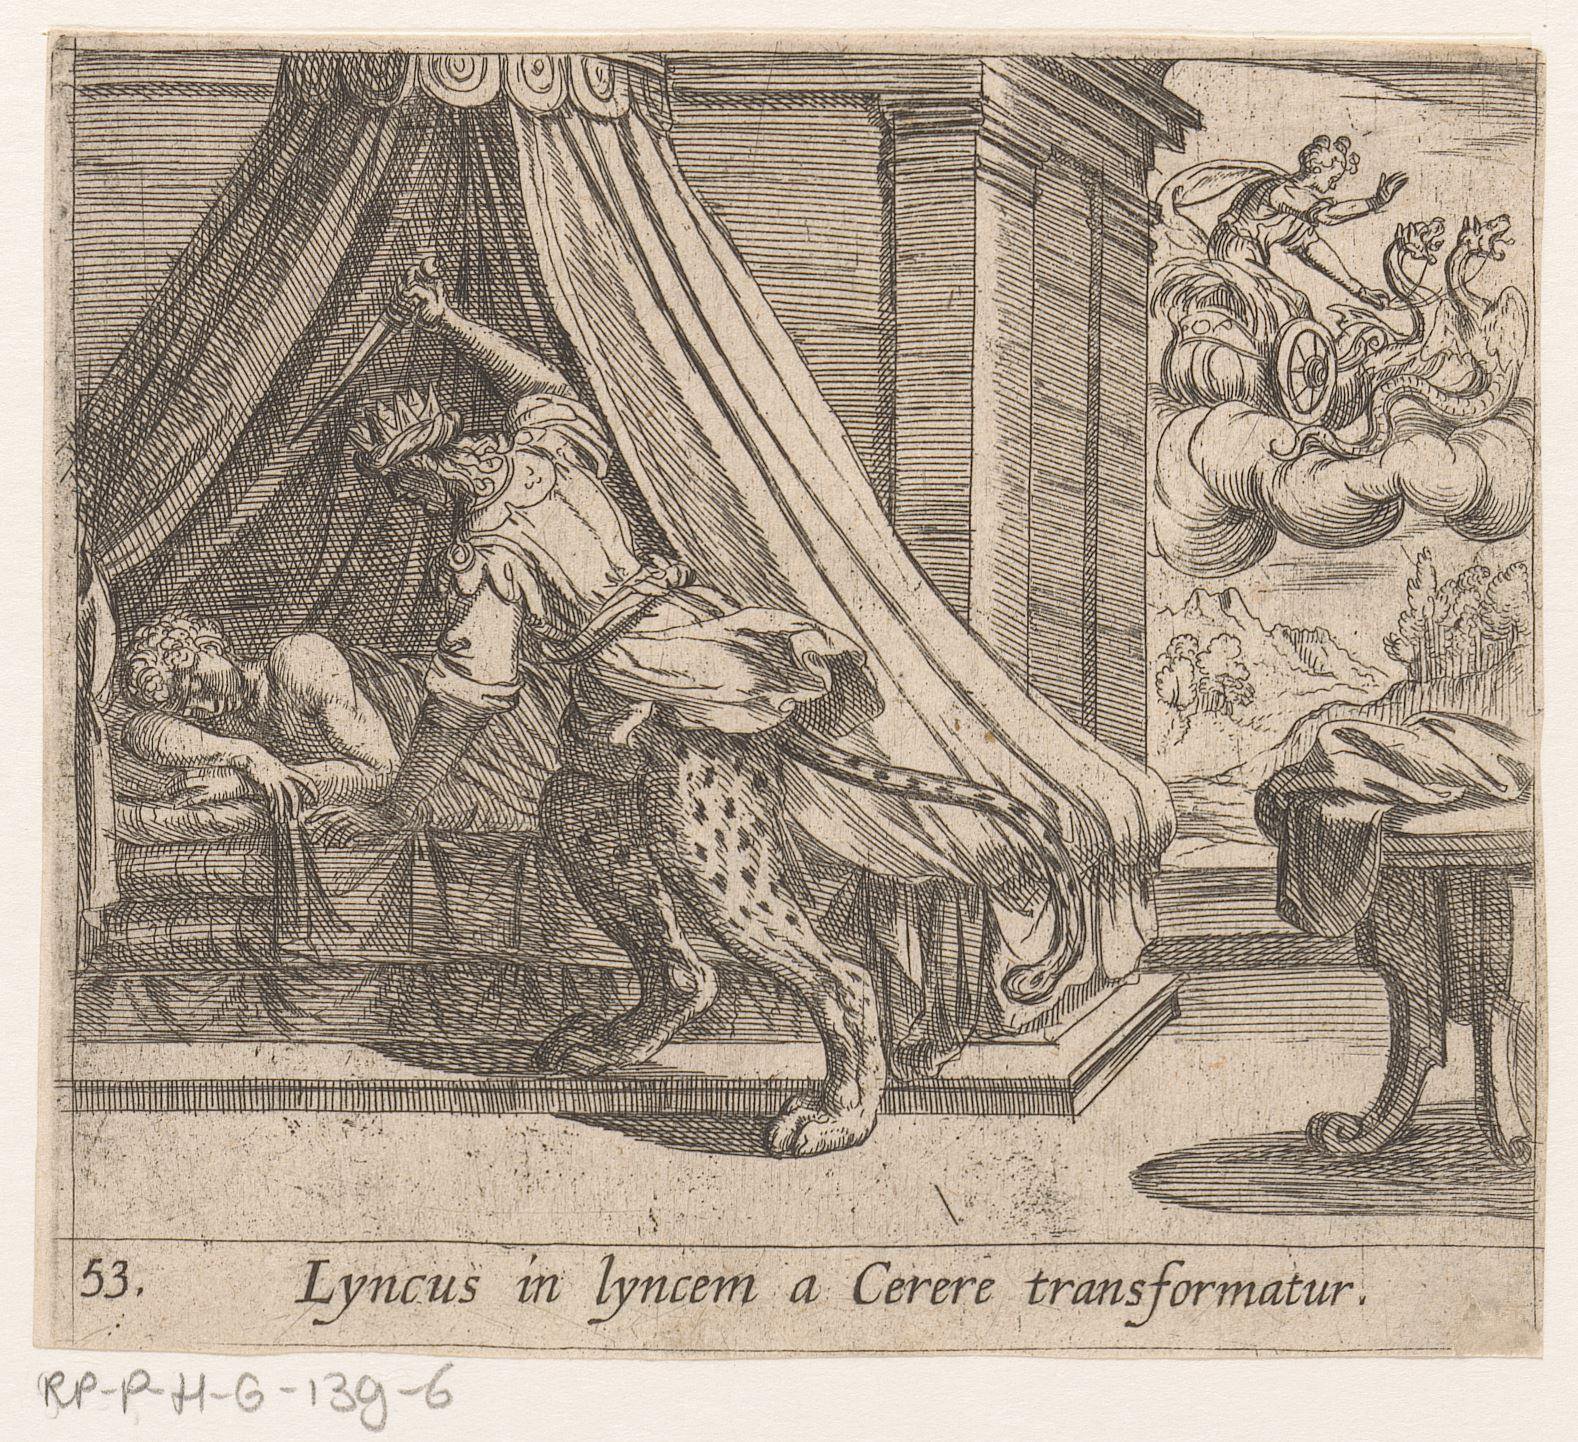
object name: print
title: Metamorphoseon sive transformationum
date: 1606-1638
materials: paper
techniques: etching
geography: italy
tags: lyncus changed into a lynx: ceres changes lyncus into a lynx when he is on the point of murdering the sleeping triptolemus (ovid, metamorphoses v 657)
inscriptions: collector's mark: ‘Hinloopen’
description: Ceres verandert Lyncus in een lynx op het moment dat hij de slapende Triptolemus probeert te doden. Titel in het Latijn in ondermarge.